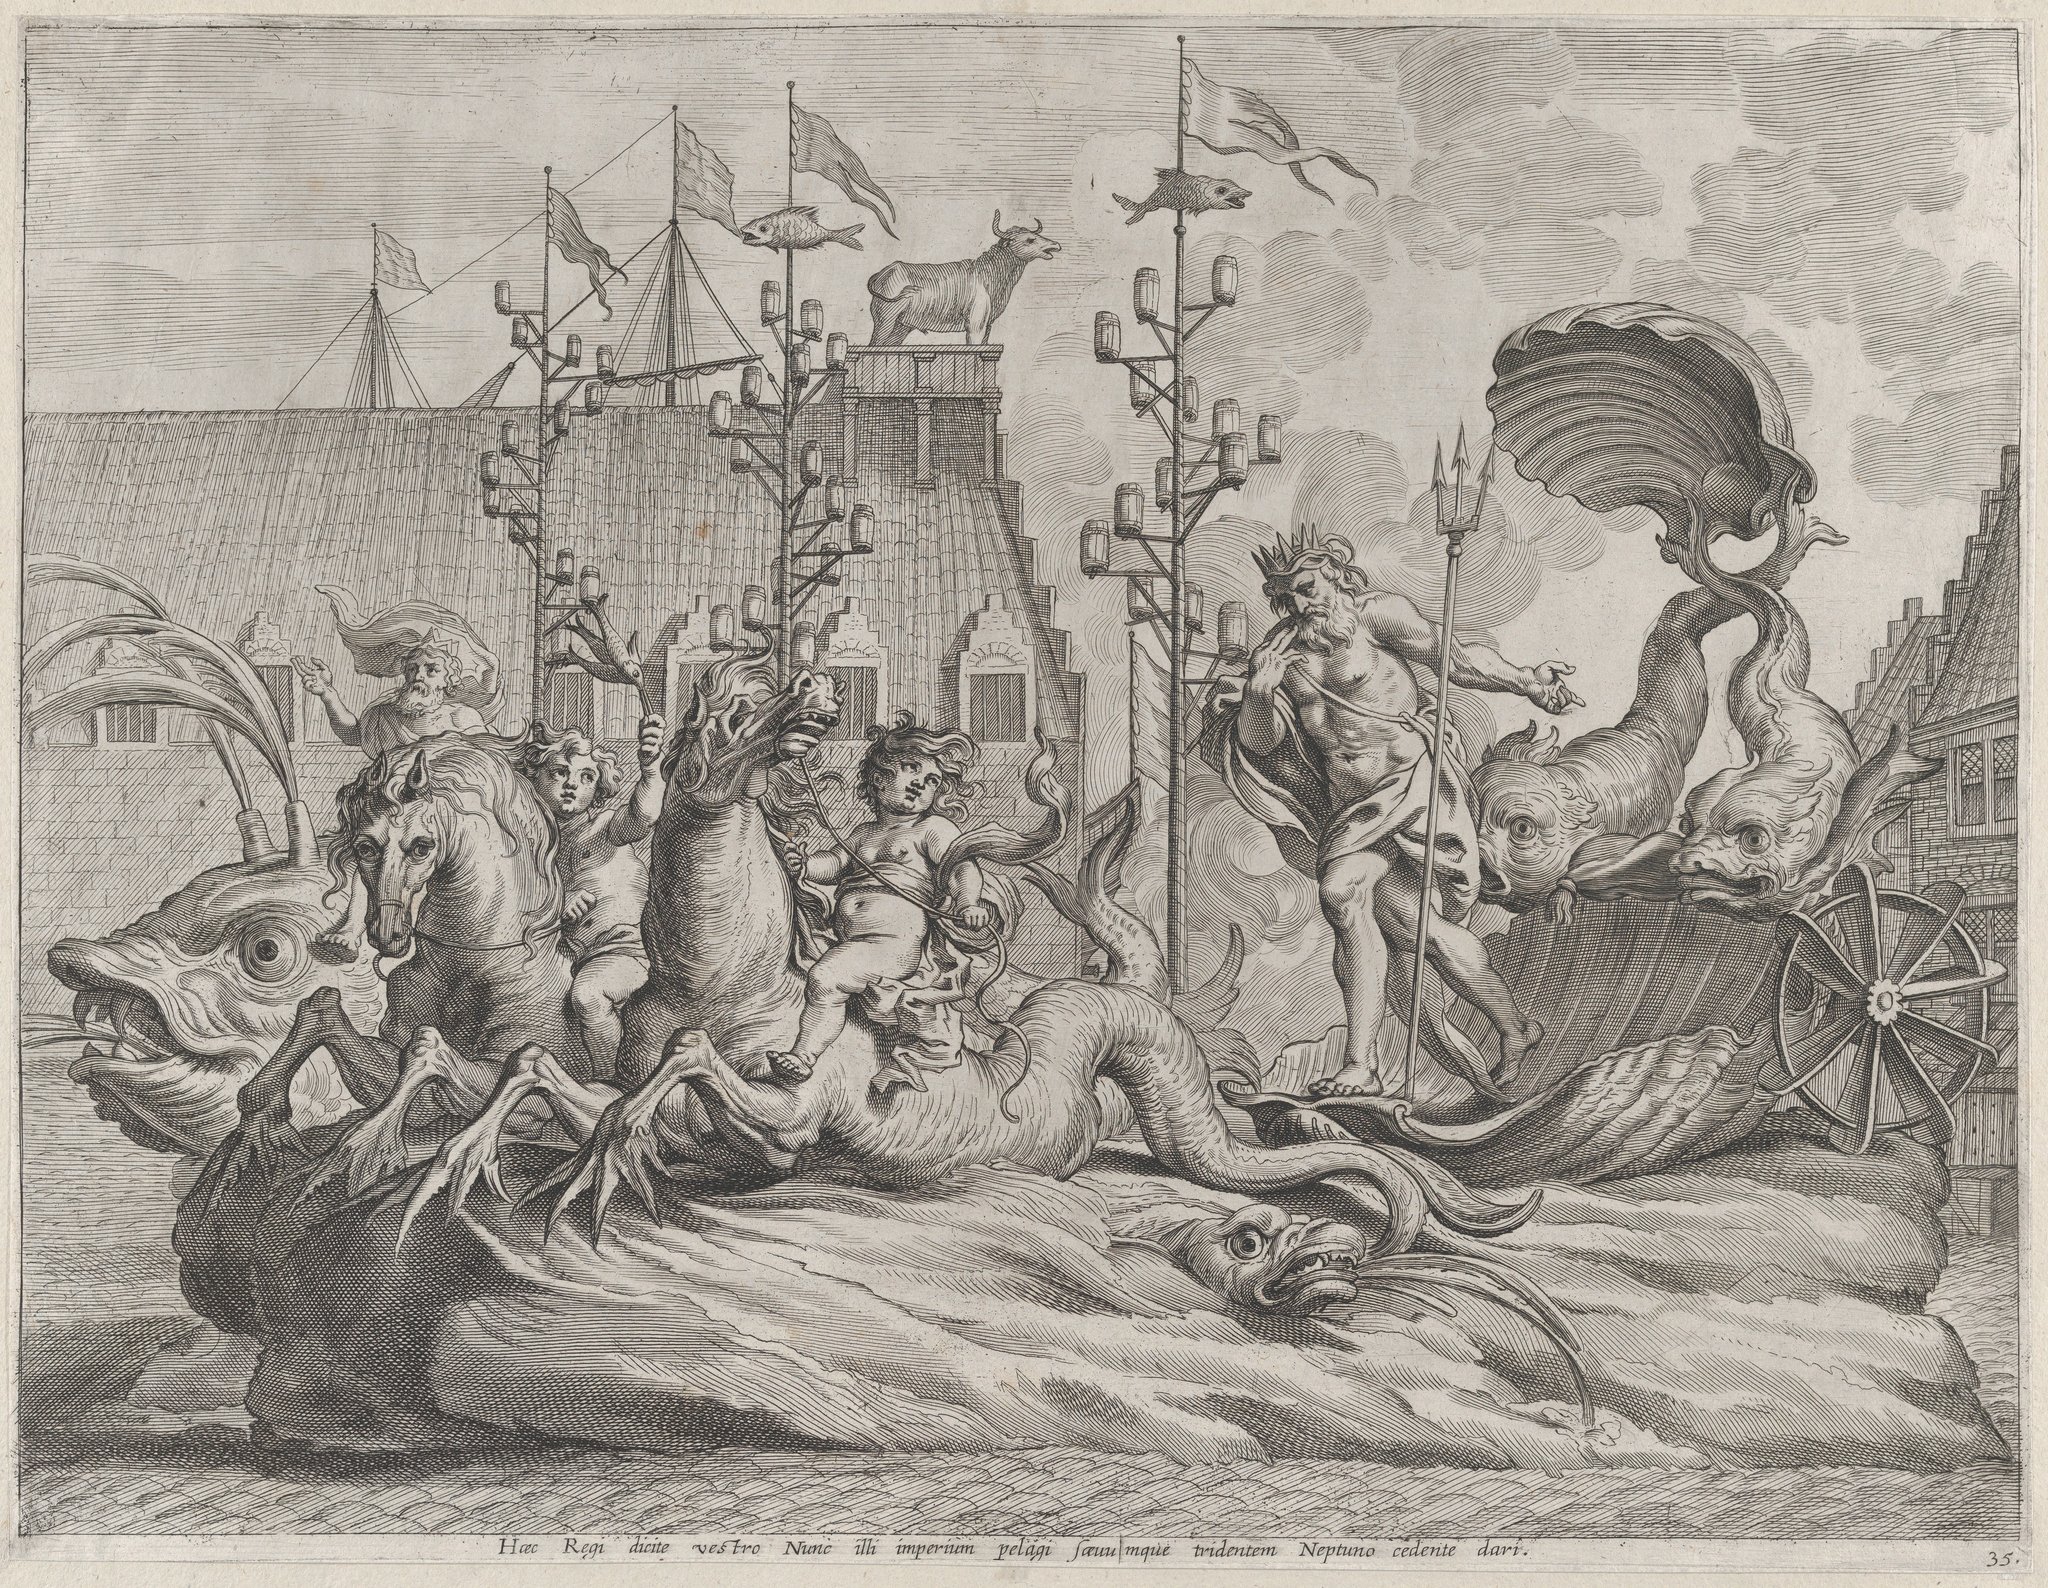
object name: print, fete, ornament architecture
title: Plate 35: Philip of Spain as Neptune, riding in a chariot drawn by two sea horses; from Guillielmus Becanus's 'Serenissimi Principis Ferdinandi, Hispaniarum Infantis...'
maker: pieter de jode (ii)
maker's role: artist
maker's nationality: flemish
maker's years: 1606-1674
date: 1636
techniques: engraving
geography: antwerp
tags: mythical creatures,neptune,fish,chariots